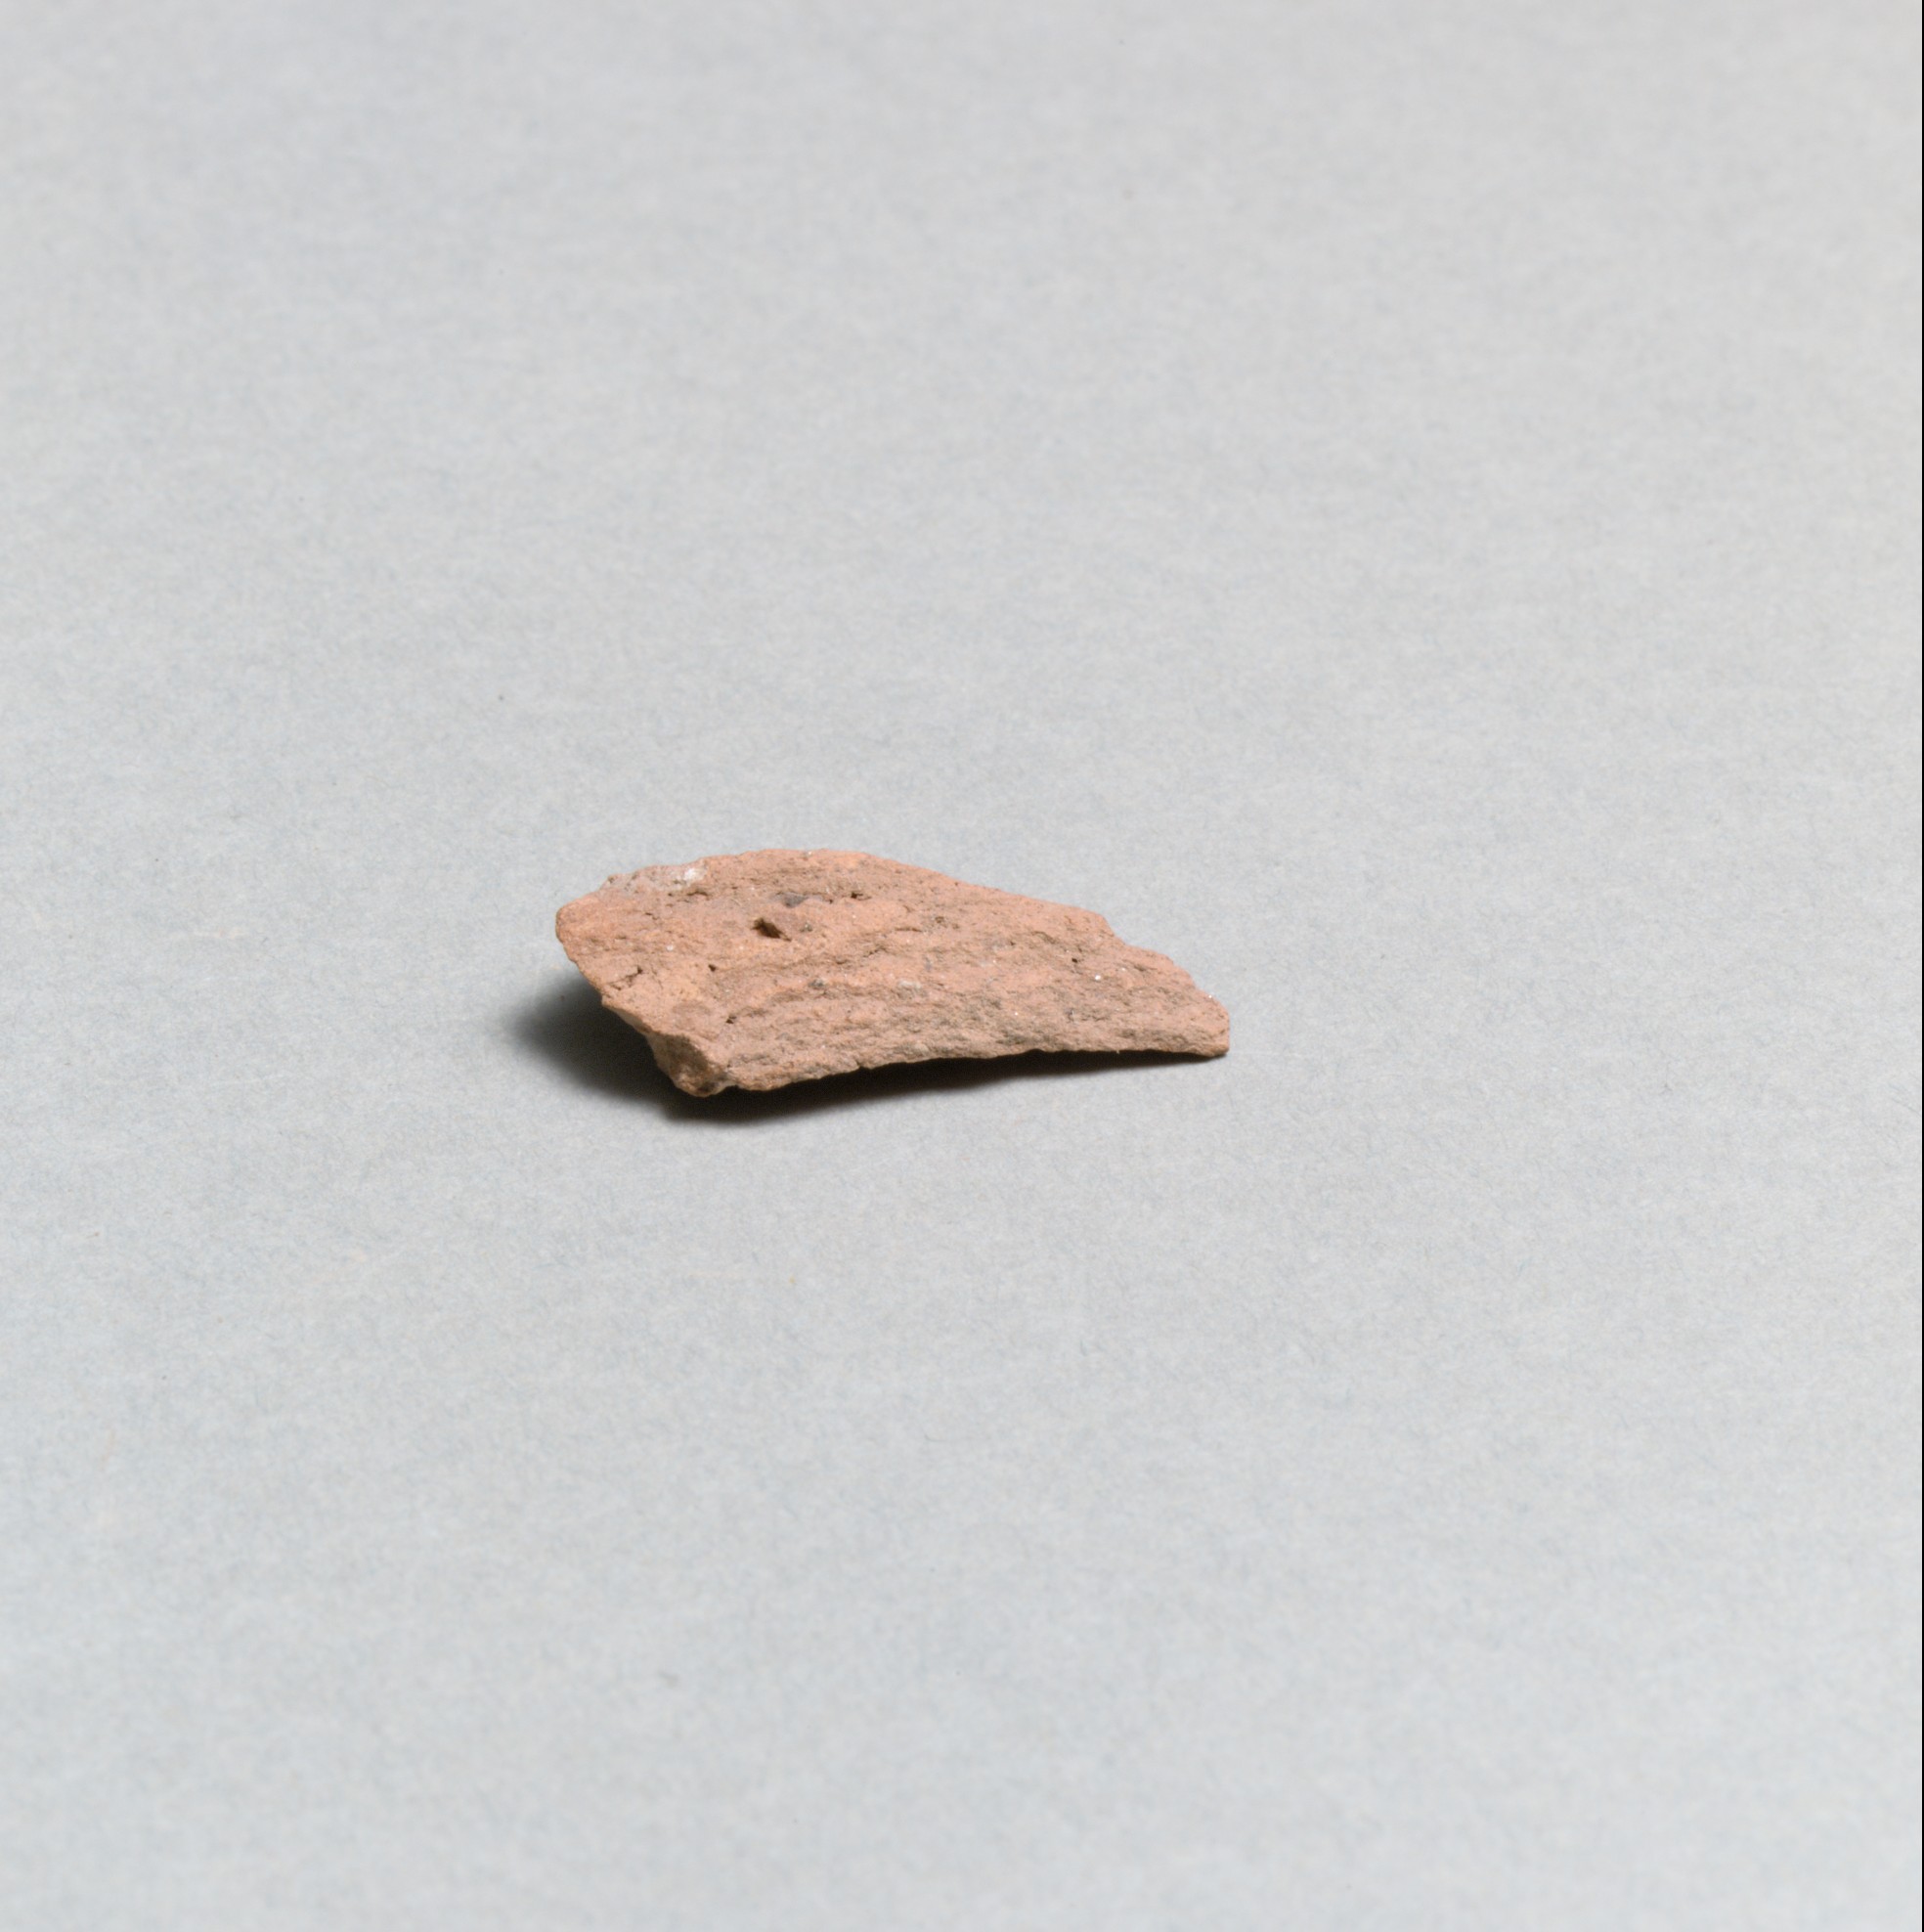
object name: vase fragment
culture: greek or lydian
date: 900-30 BCE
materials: terracotta